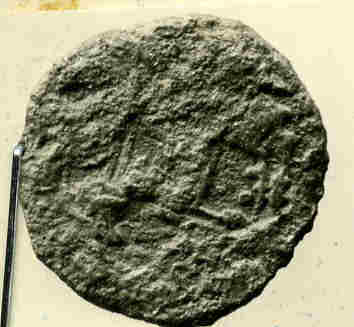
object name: coin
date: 701-900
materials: copper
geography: iran